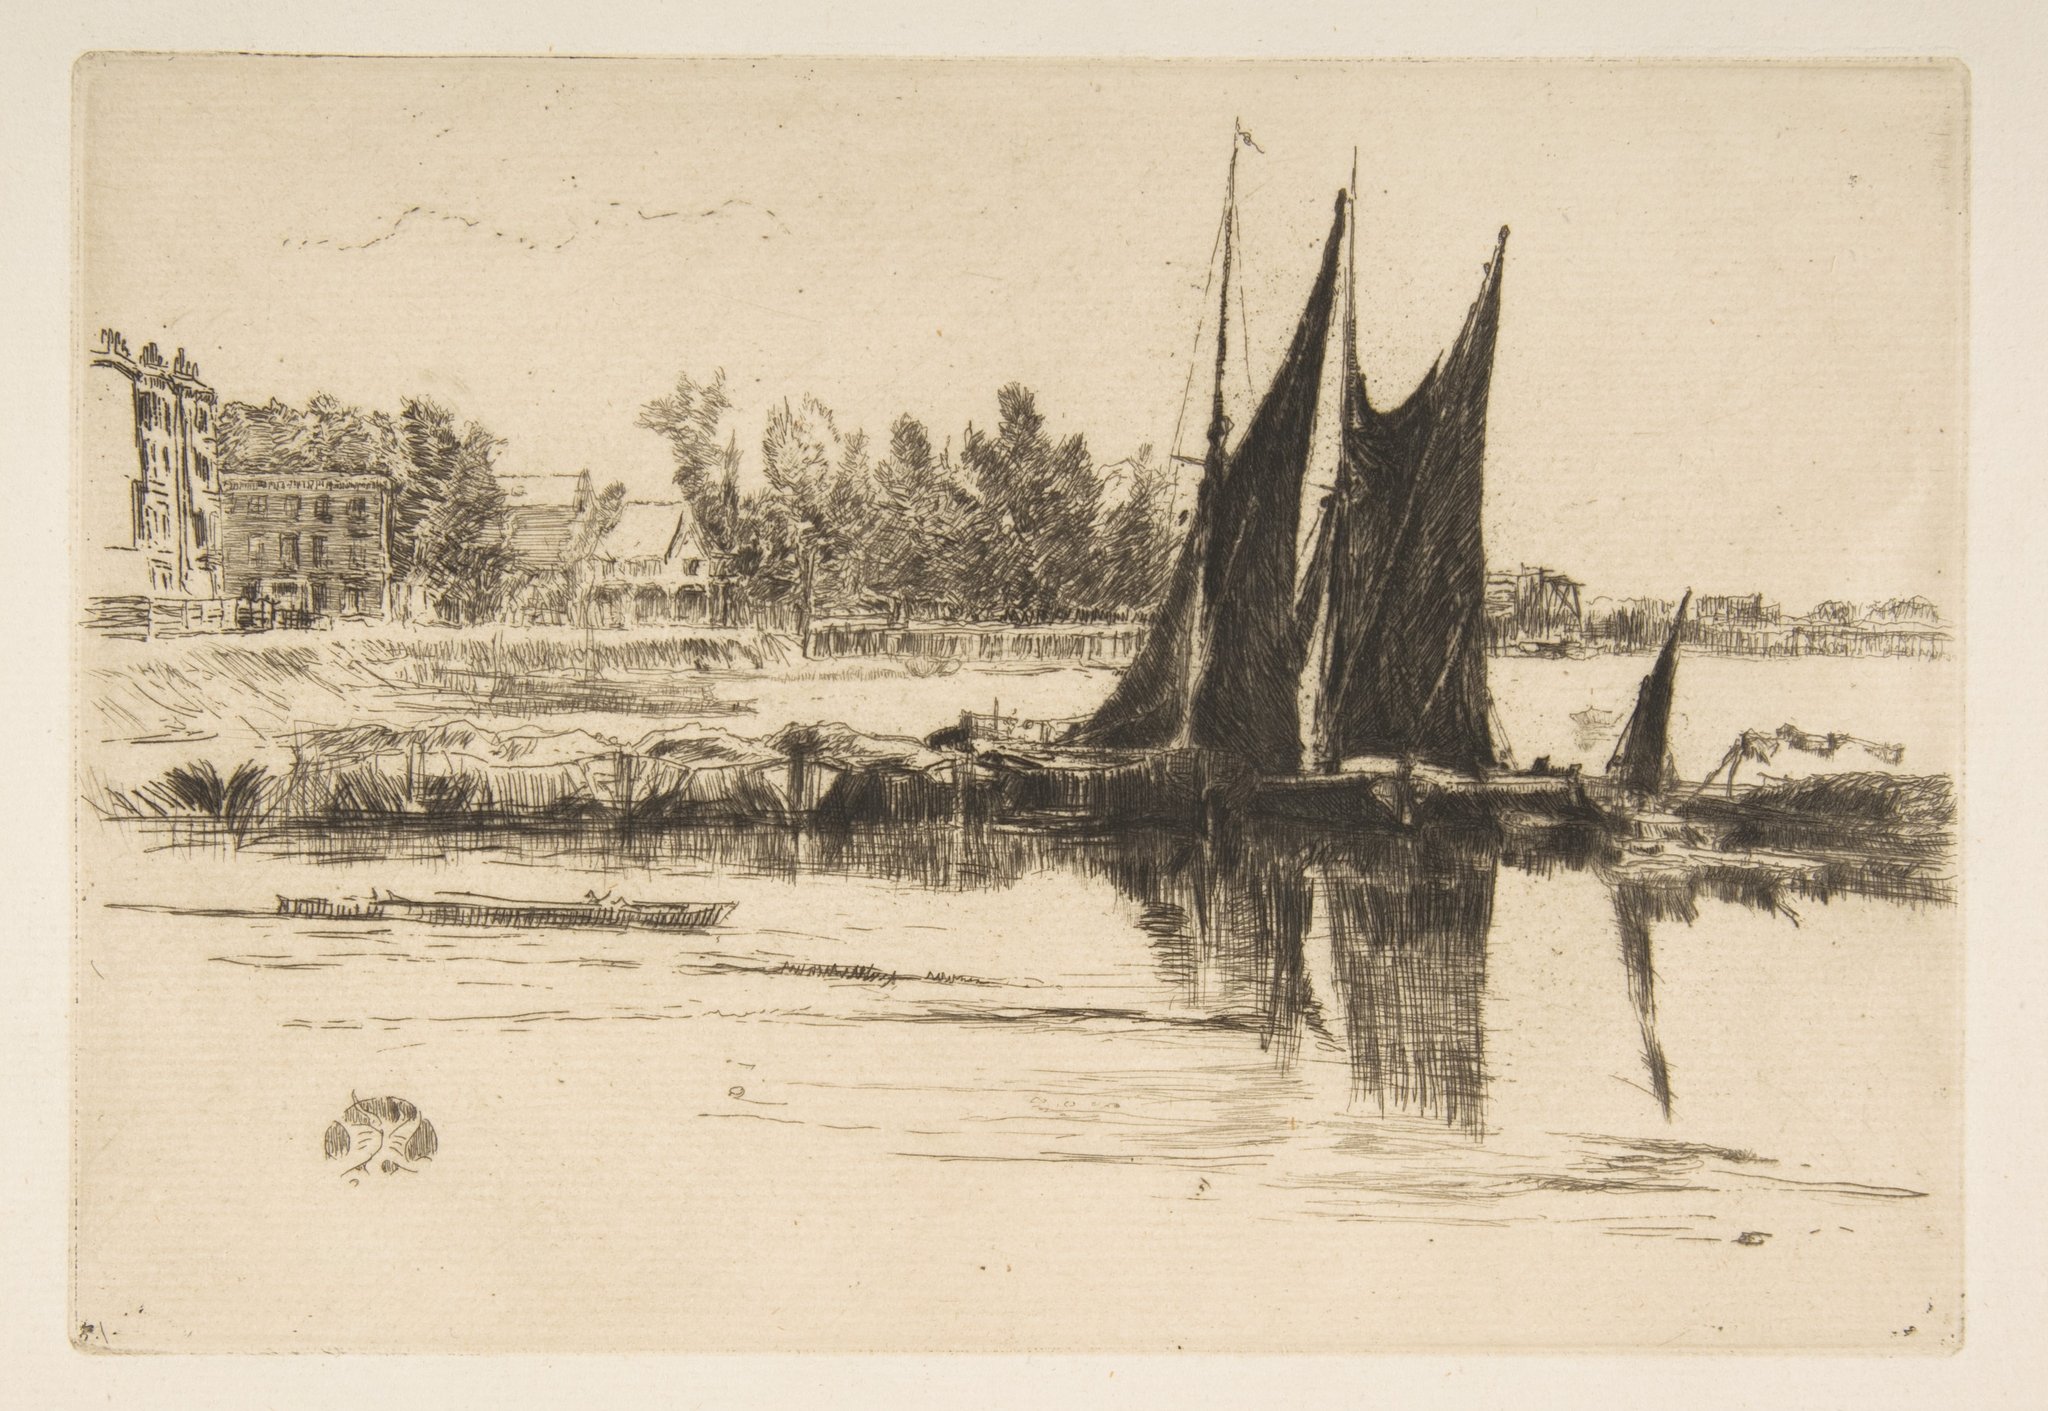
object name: print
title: Hurlingham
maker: james mcneill whistler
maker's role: artist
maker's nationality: american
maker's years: 1834-1903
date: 1879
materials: ink, paper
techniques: drypoint, etching, printing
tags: rivers,boats